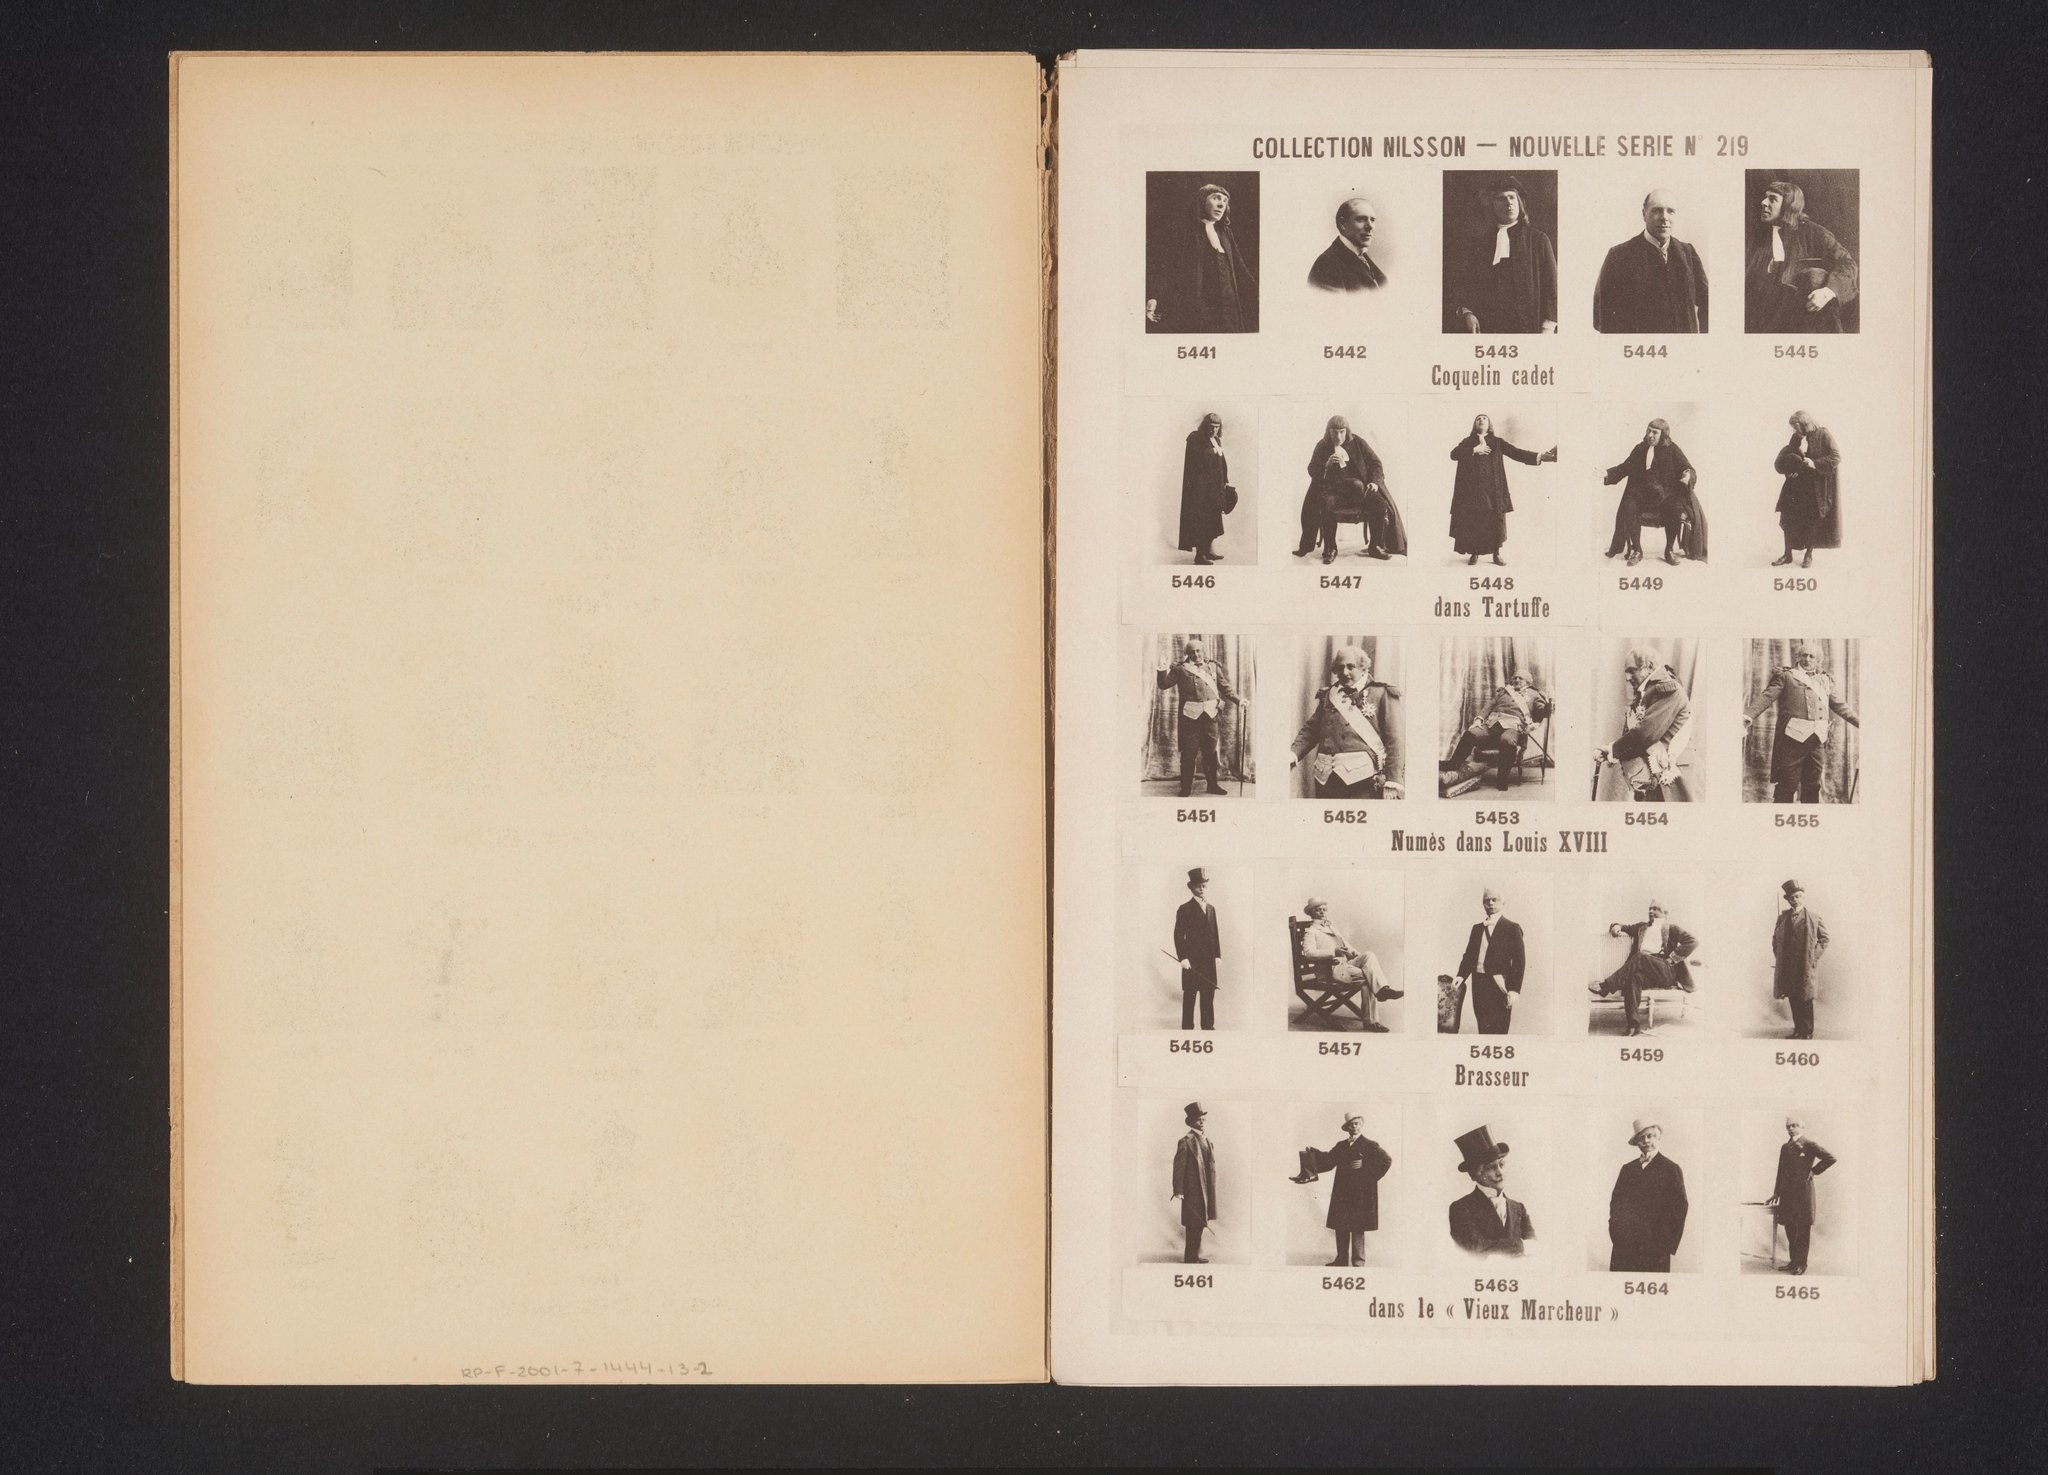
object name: page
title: 25 portretten van Coquelin, Numès en Brasseur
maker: Anonymous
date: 1894-1899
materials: paper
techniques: photograph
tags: historical persons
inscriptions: inscription: ‘Coquelin cadet/ dans Tartuffe/ Numès dans Louis XVIII/ Brasseur/ dans le < < Vieux Marcheur > >’, number: ‘No 219’